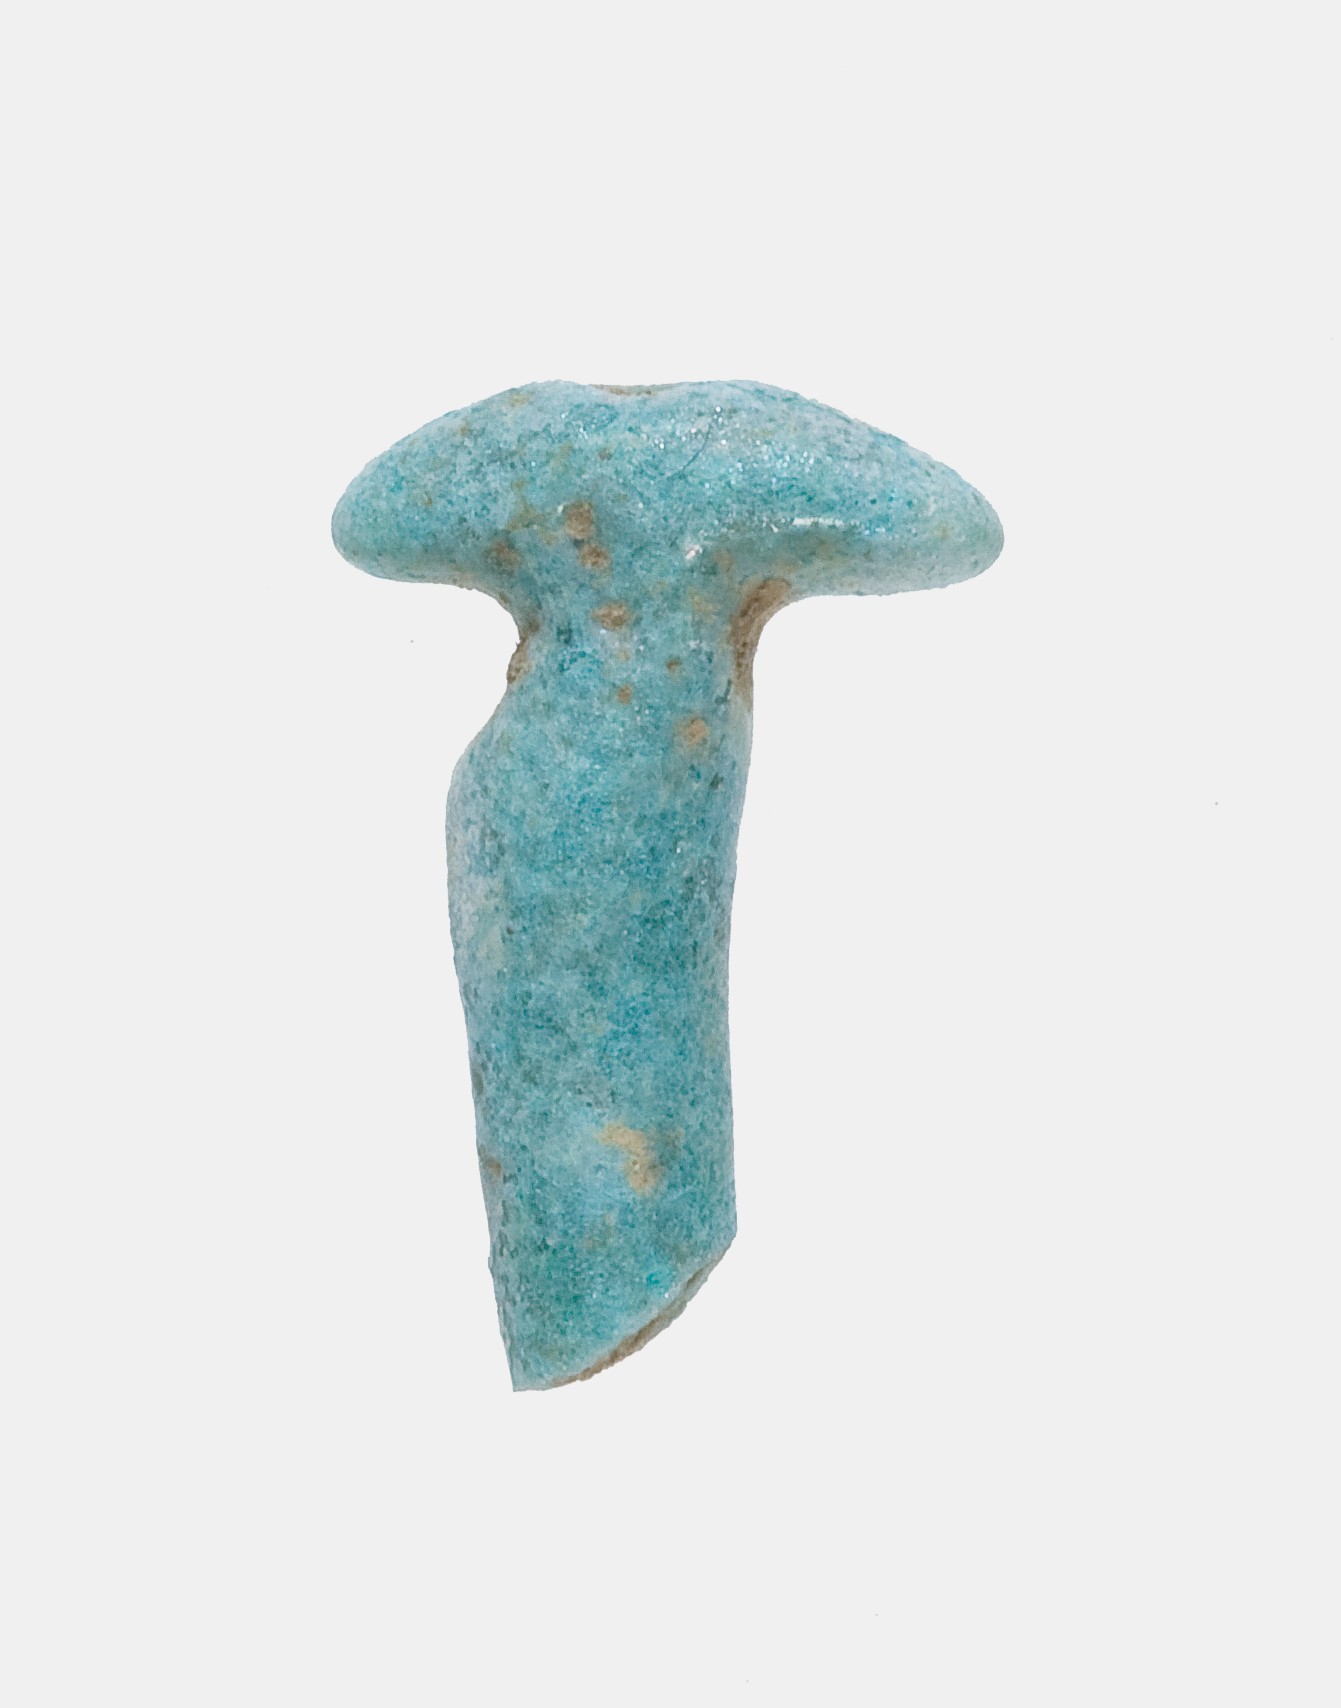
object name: necklace, bead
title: Amulet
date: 1802-1450 BCE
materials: faience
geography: egypt